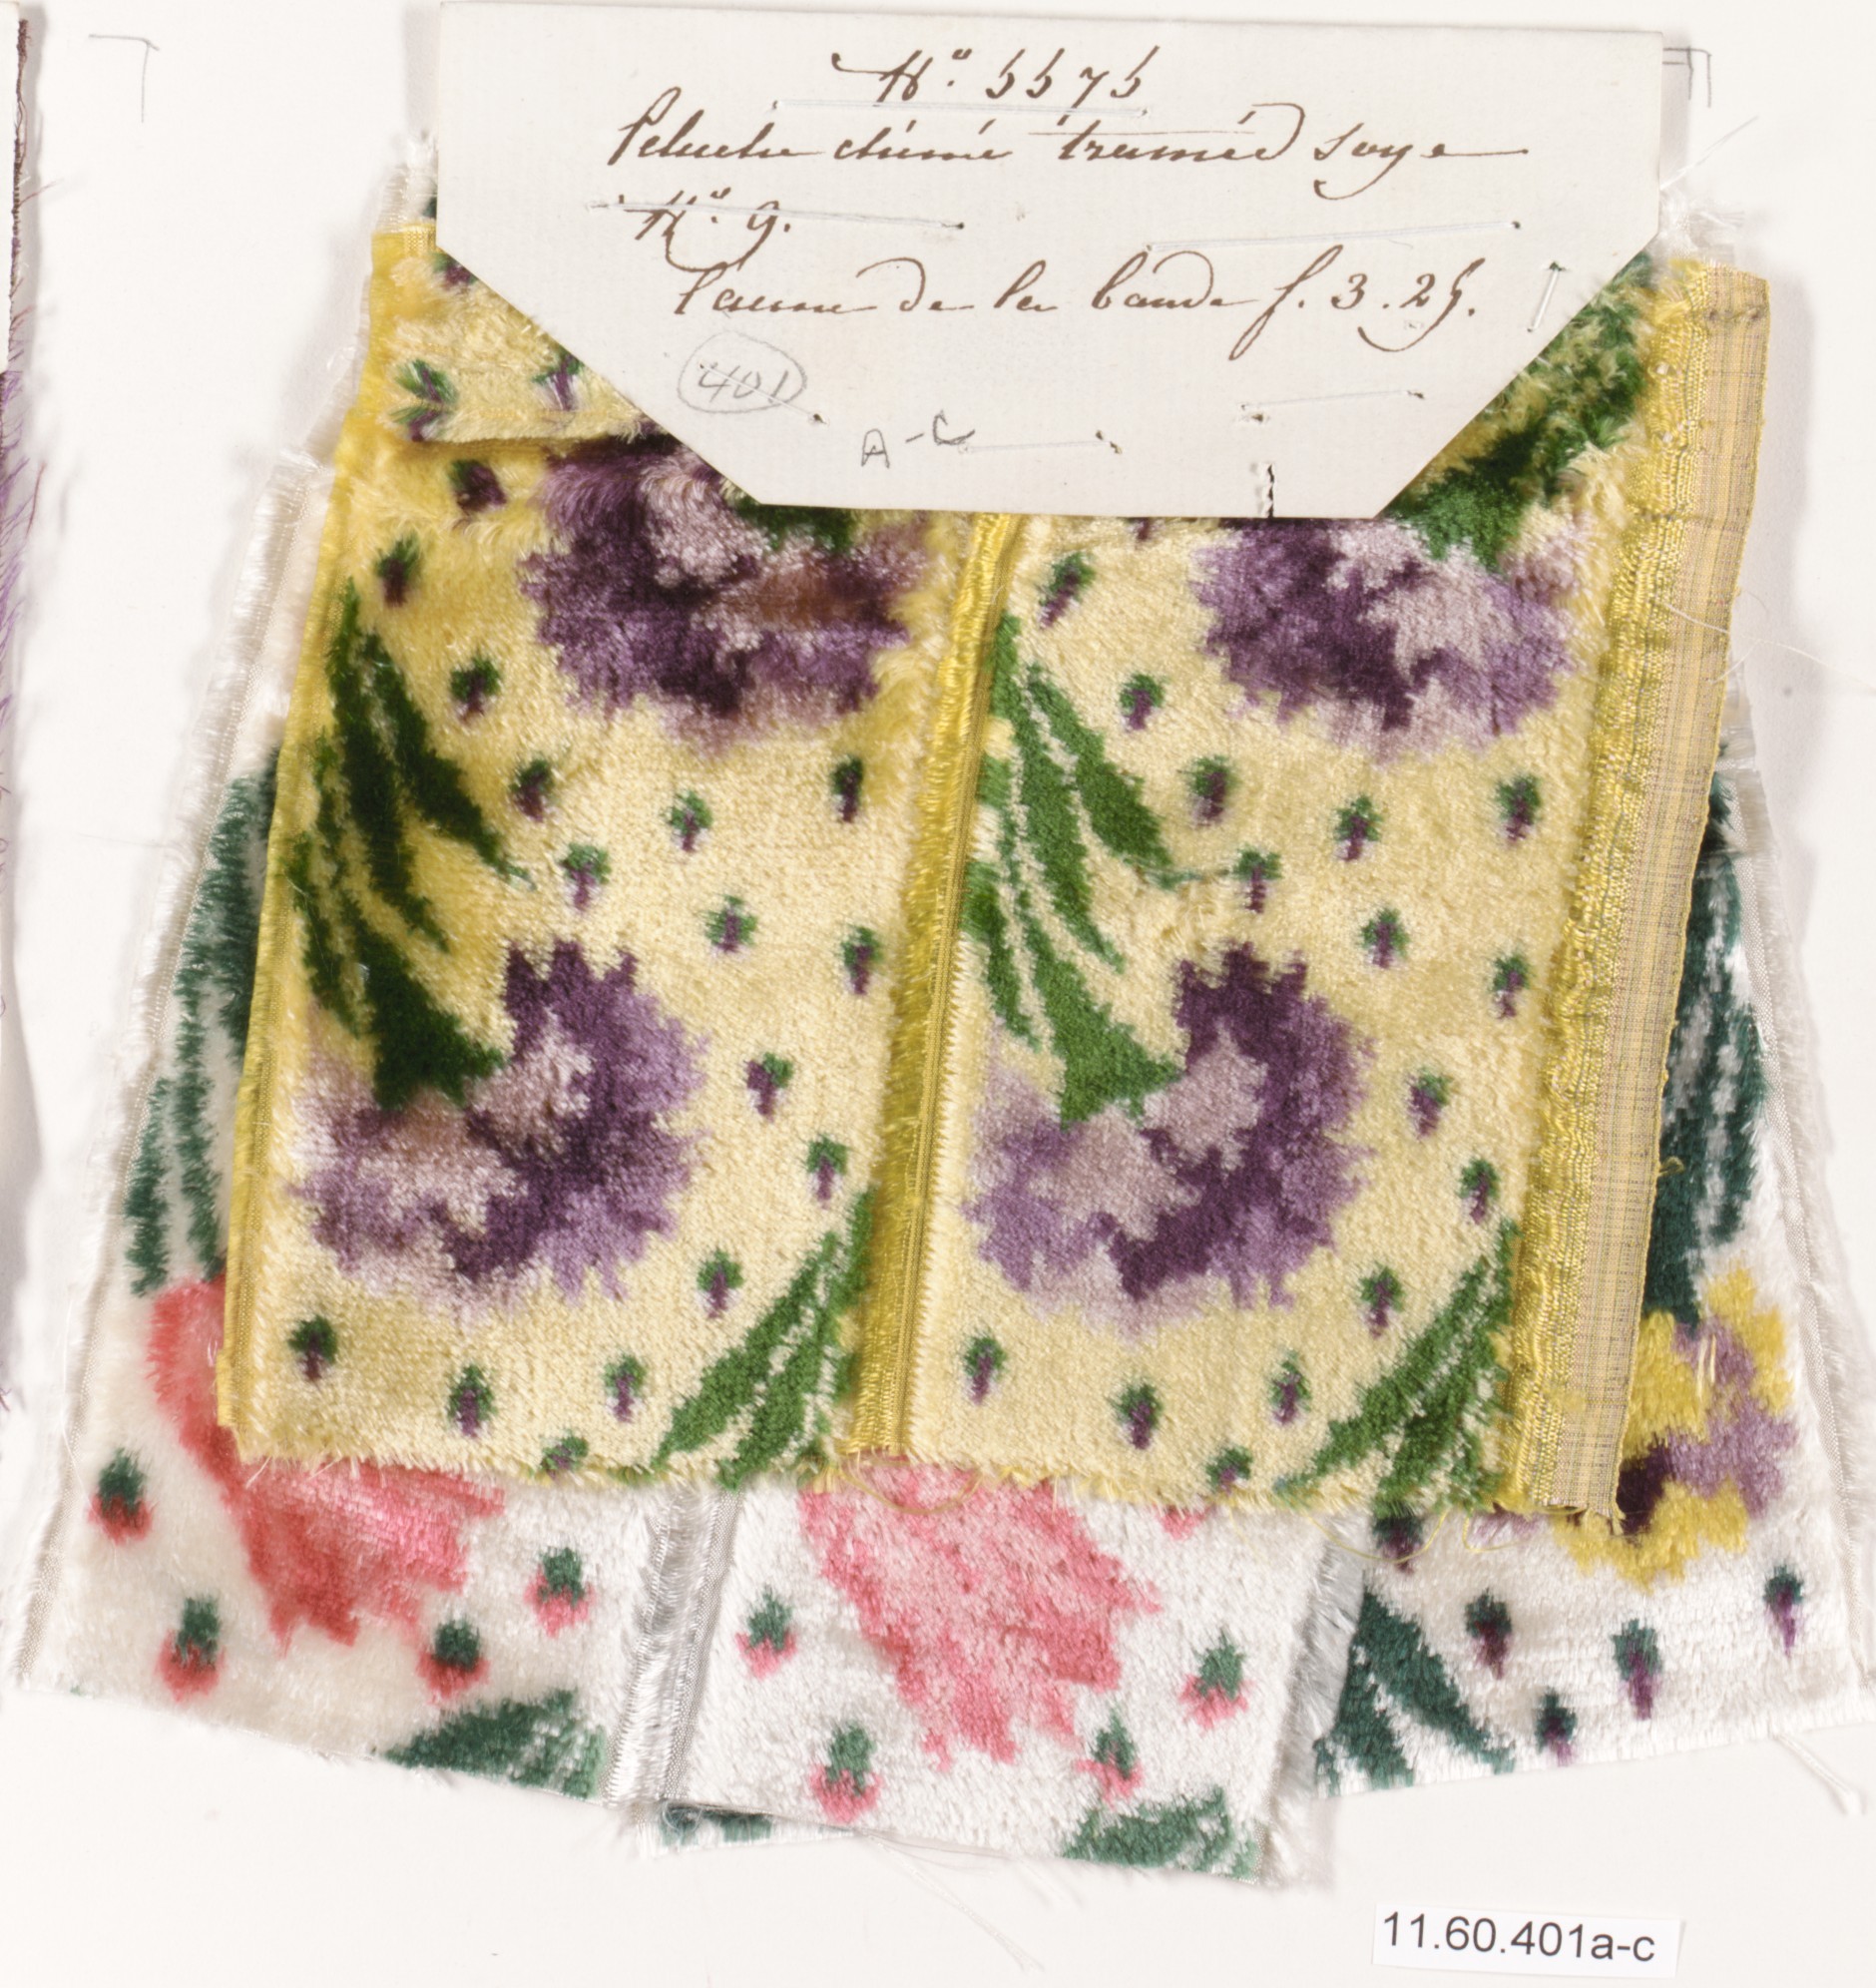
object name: fragment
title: Fragments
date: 1801-1900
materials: silk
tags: flowers,leaves